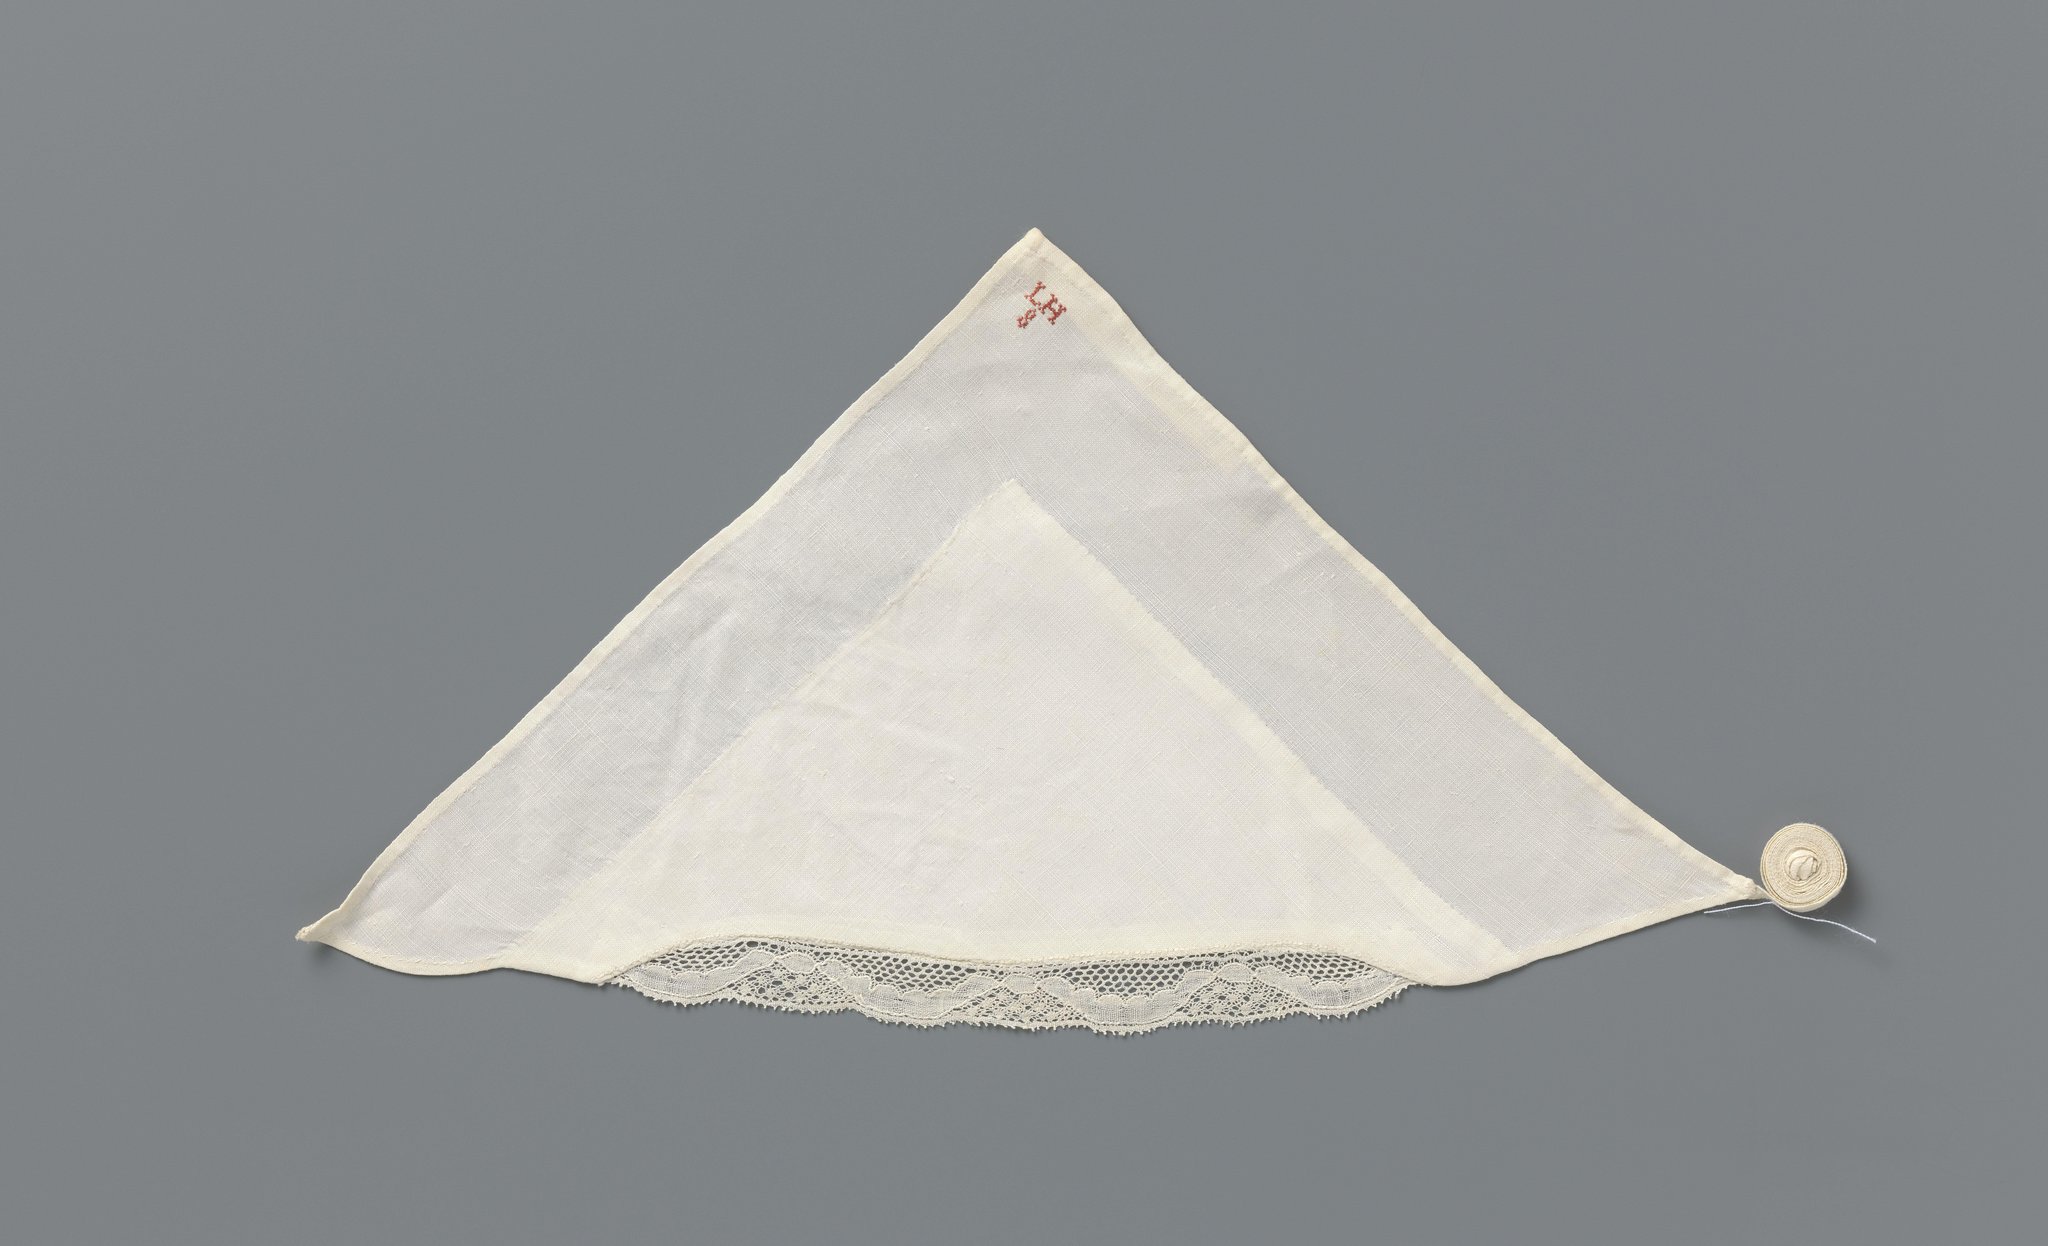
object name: fontaneldoek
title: Fontaneldoek van wit linnen met kant; in rode kruissteek gemerkt: LH8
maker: Anonymous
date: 1750-1900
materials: linen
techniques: cross stitching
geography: europe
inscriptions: inscription: ‘LH / 8’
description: 12 linnen fontanelletjes met verschillende kant afgezet , 4 gemerkt LH8, 3 gem. H8, 5 gem. HVS(Gr. Hoogenhuize "1772-1852" tr. 1802 S.E. von schmid "1771-1843"). 1 van damast gem. HH6 (W.r. Hoogenhuize "1747-1804" tr 1787 W. Helmerich "1752").